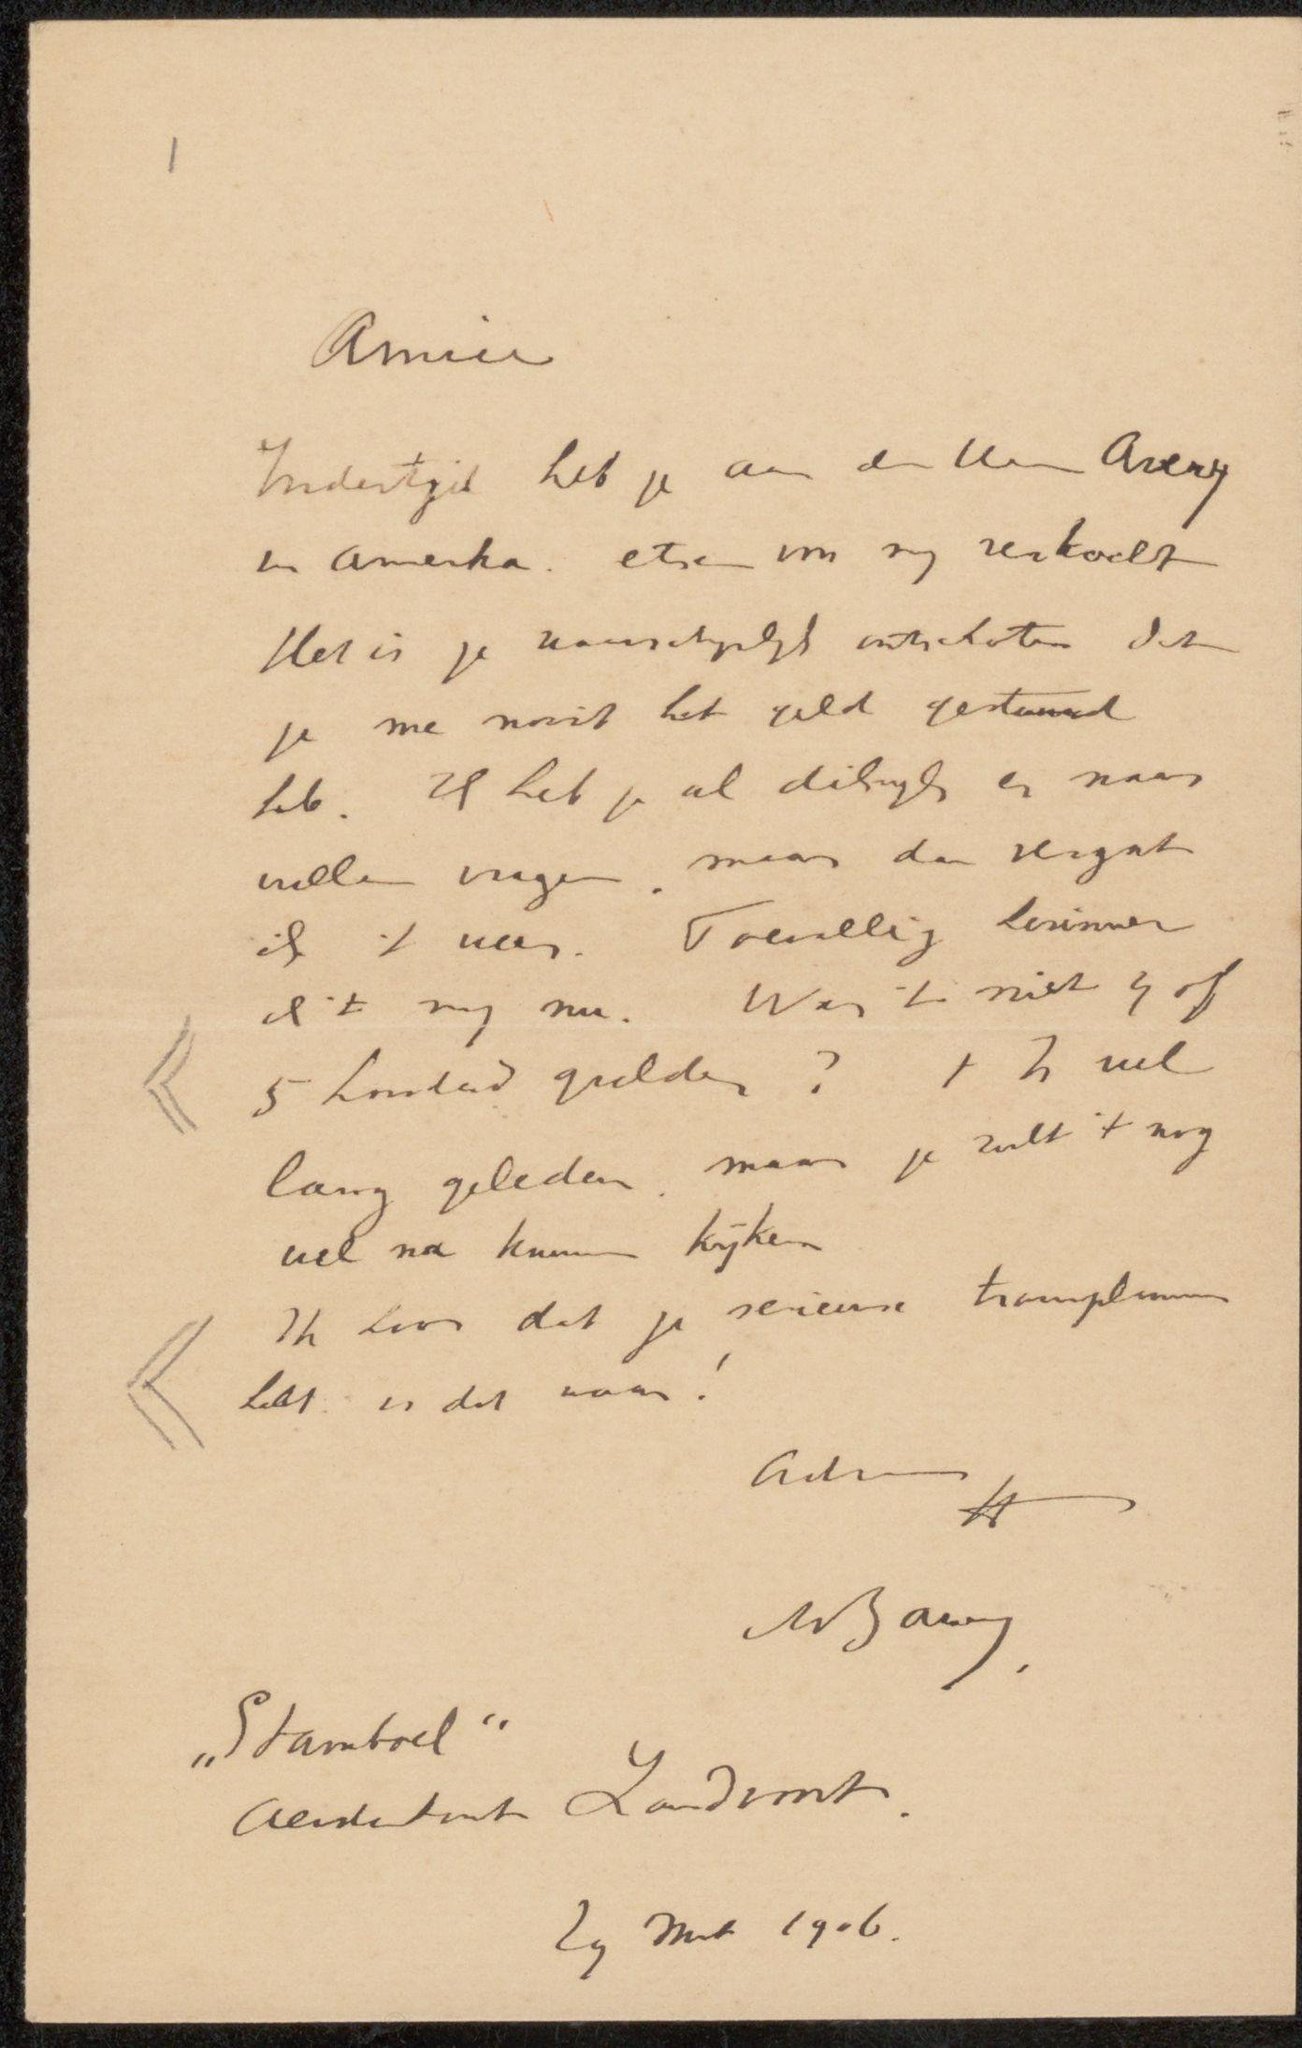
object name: letter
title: Brief aan Philip Zilcken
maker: marius bauer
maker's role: draughtsman, print maker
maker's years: 1867-1932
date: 1906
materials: ink, paper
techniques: pen, writing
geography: aerdenhout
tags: new york (city), samuel putnam avery, the hague, painter, draughtsman, philip zilcken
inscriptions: collector's mark: ‘RPK’